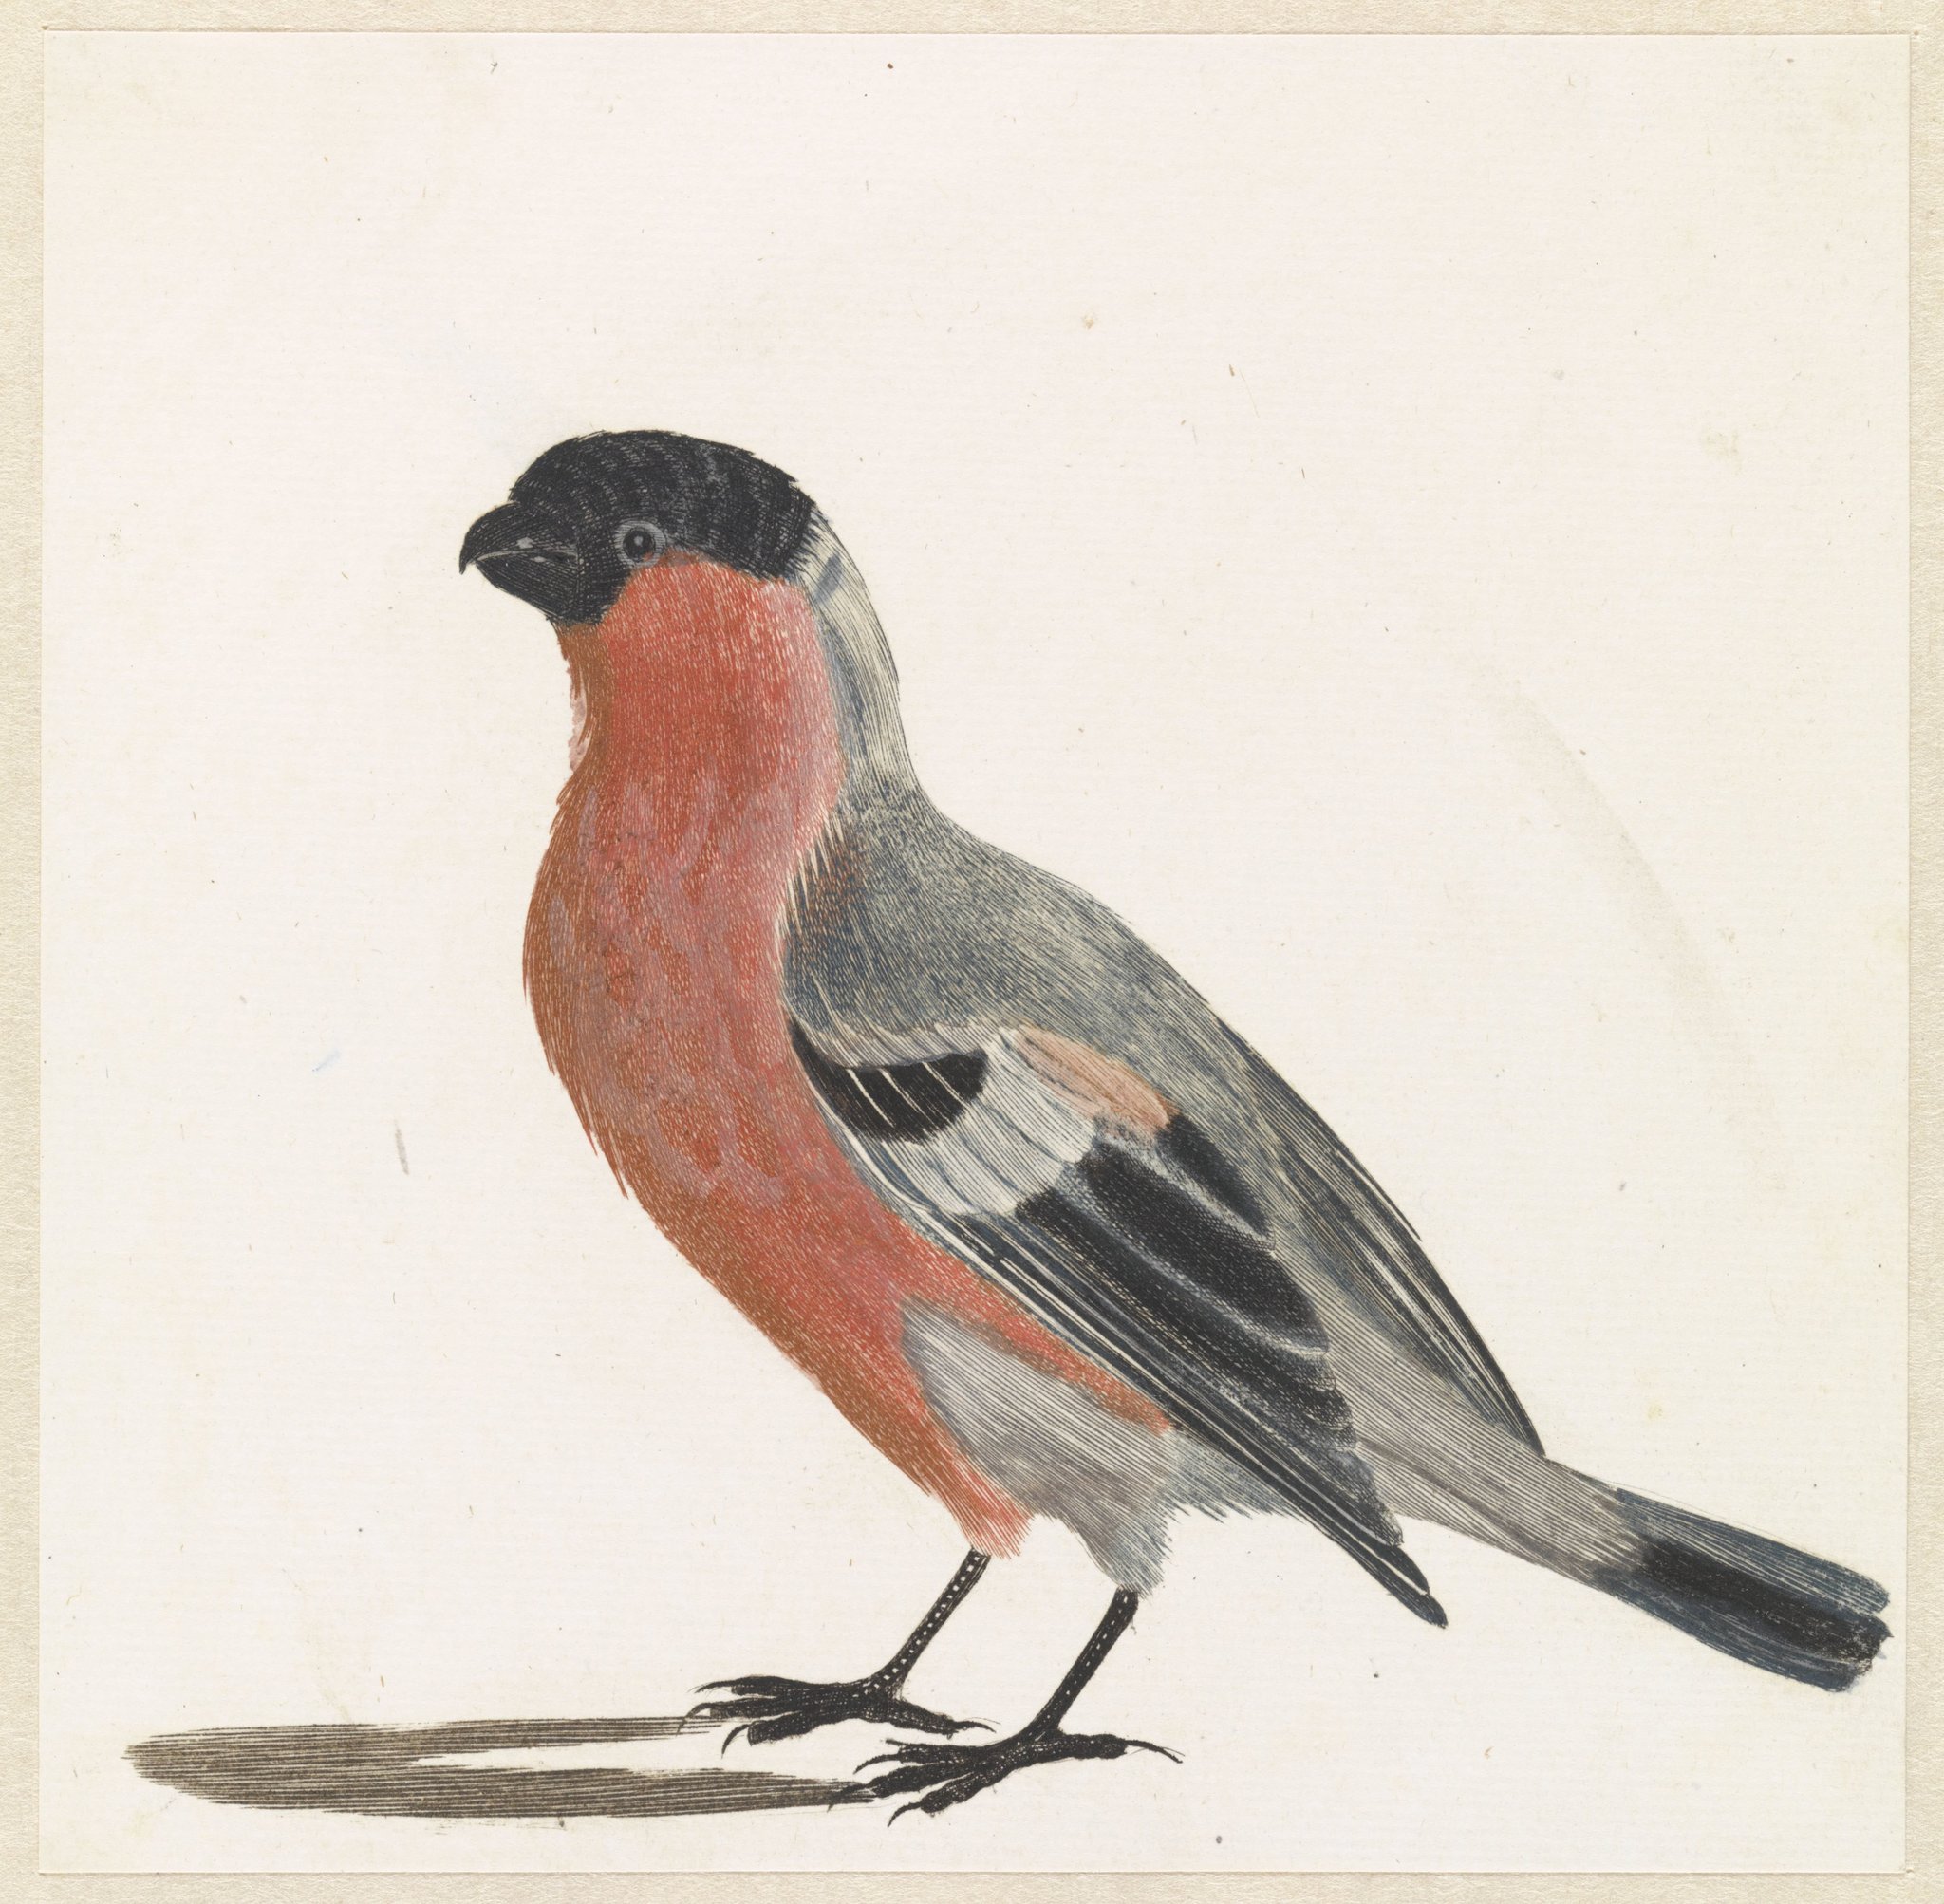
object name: print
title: Goudvink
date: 1688-1698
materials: paper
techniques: printing, engraving, lithography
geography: netherlands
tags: song-birds: goldfinch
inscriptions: collector's mark: Lugt 2228